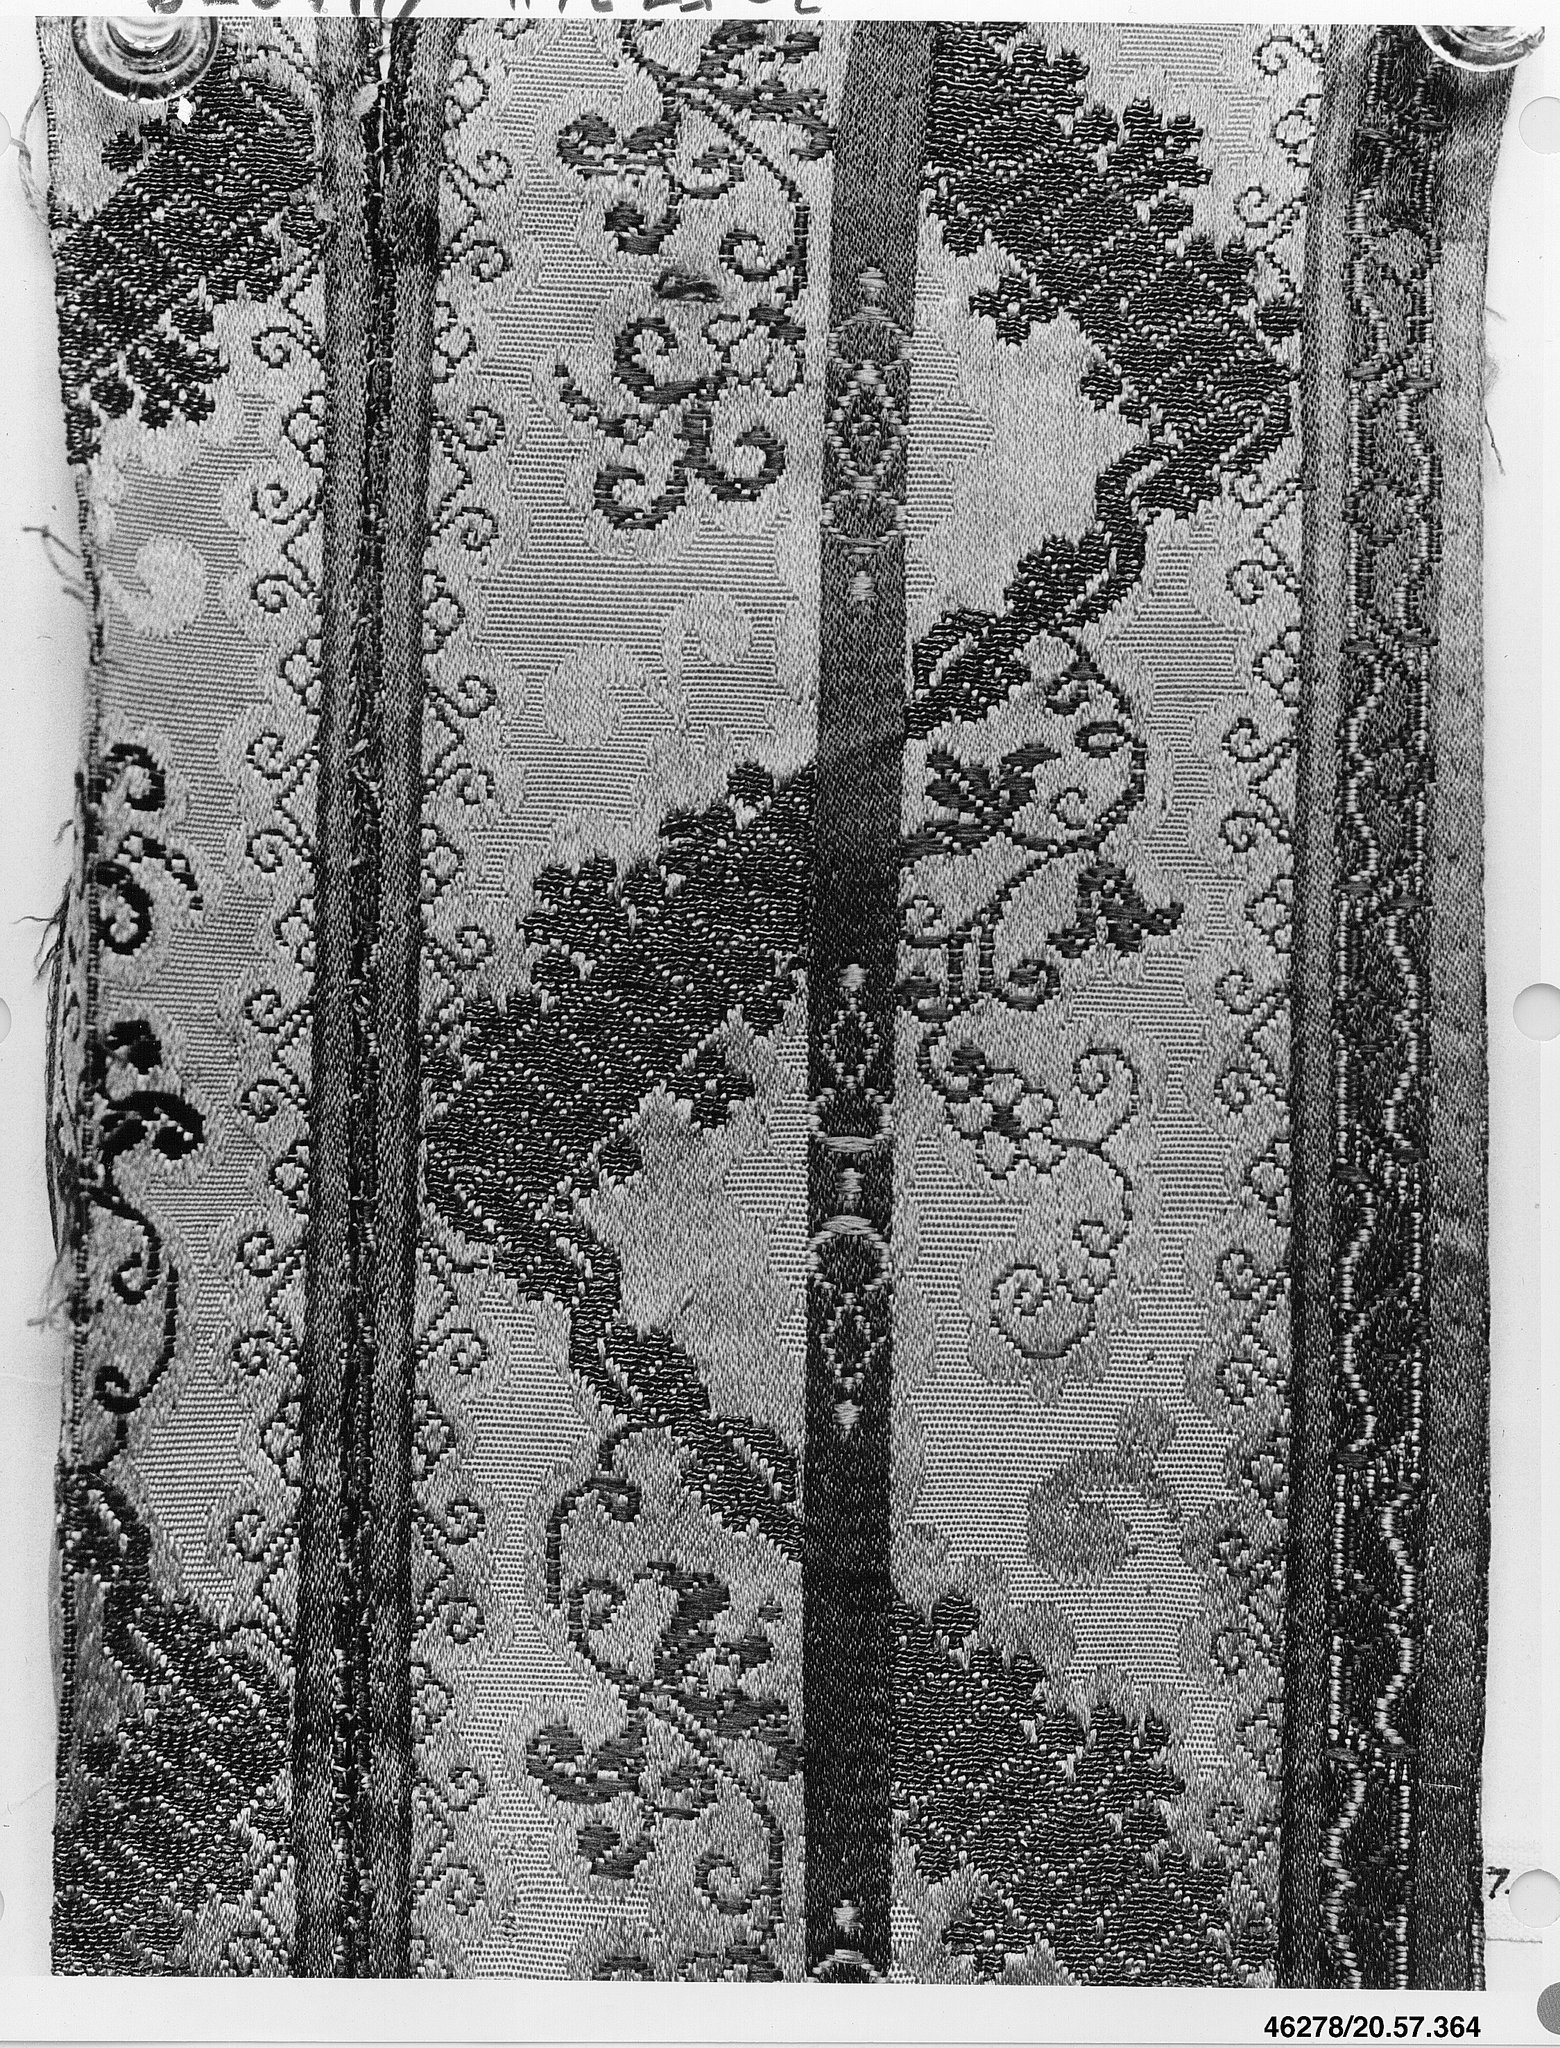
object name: piece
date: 1701-1800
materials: metal thread, silk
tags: flowers,leaves